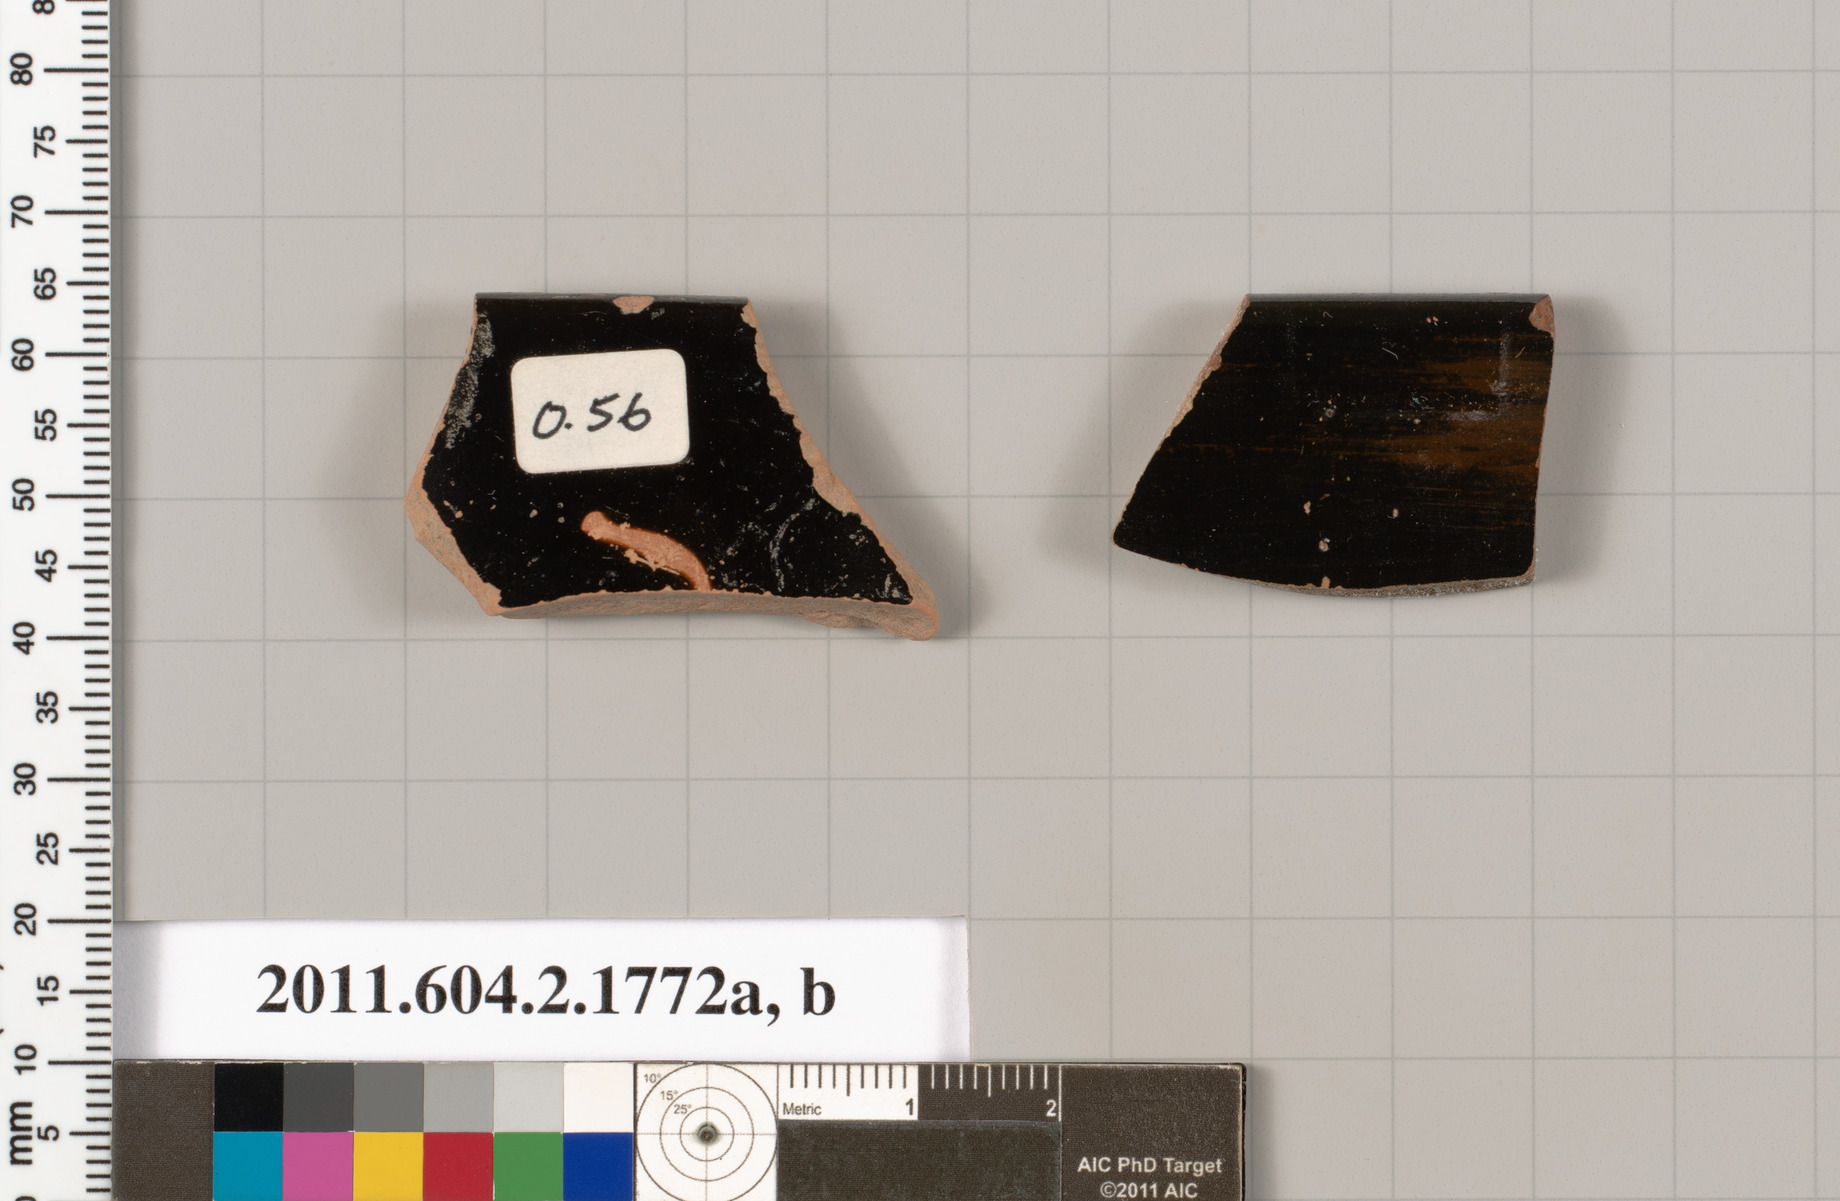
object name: skyphos fragment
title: Terracotta rim fragments of skyphoi (deep drinking cups)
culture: greek, attic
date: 475-451 BCE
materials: terracotta